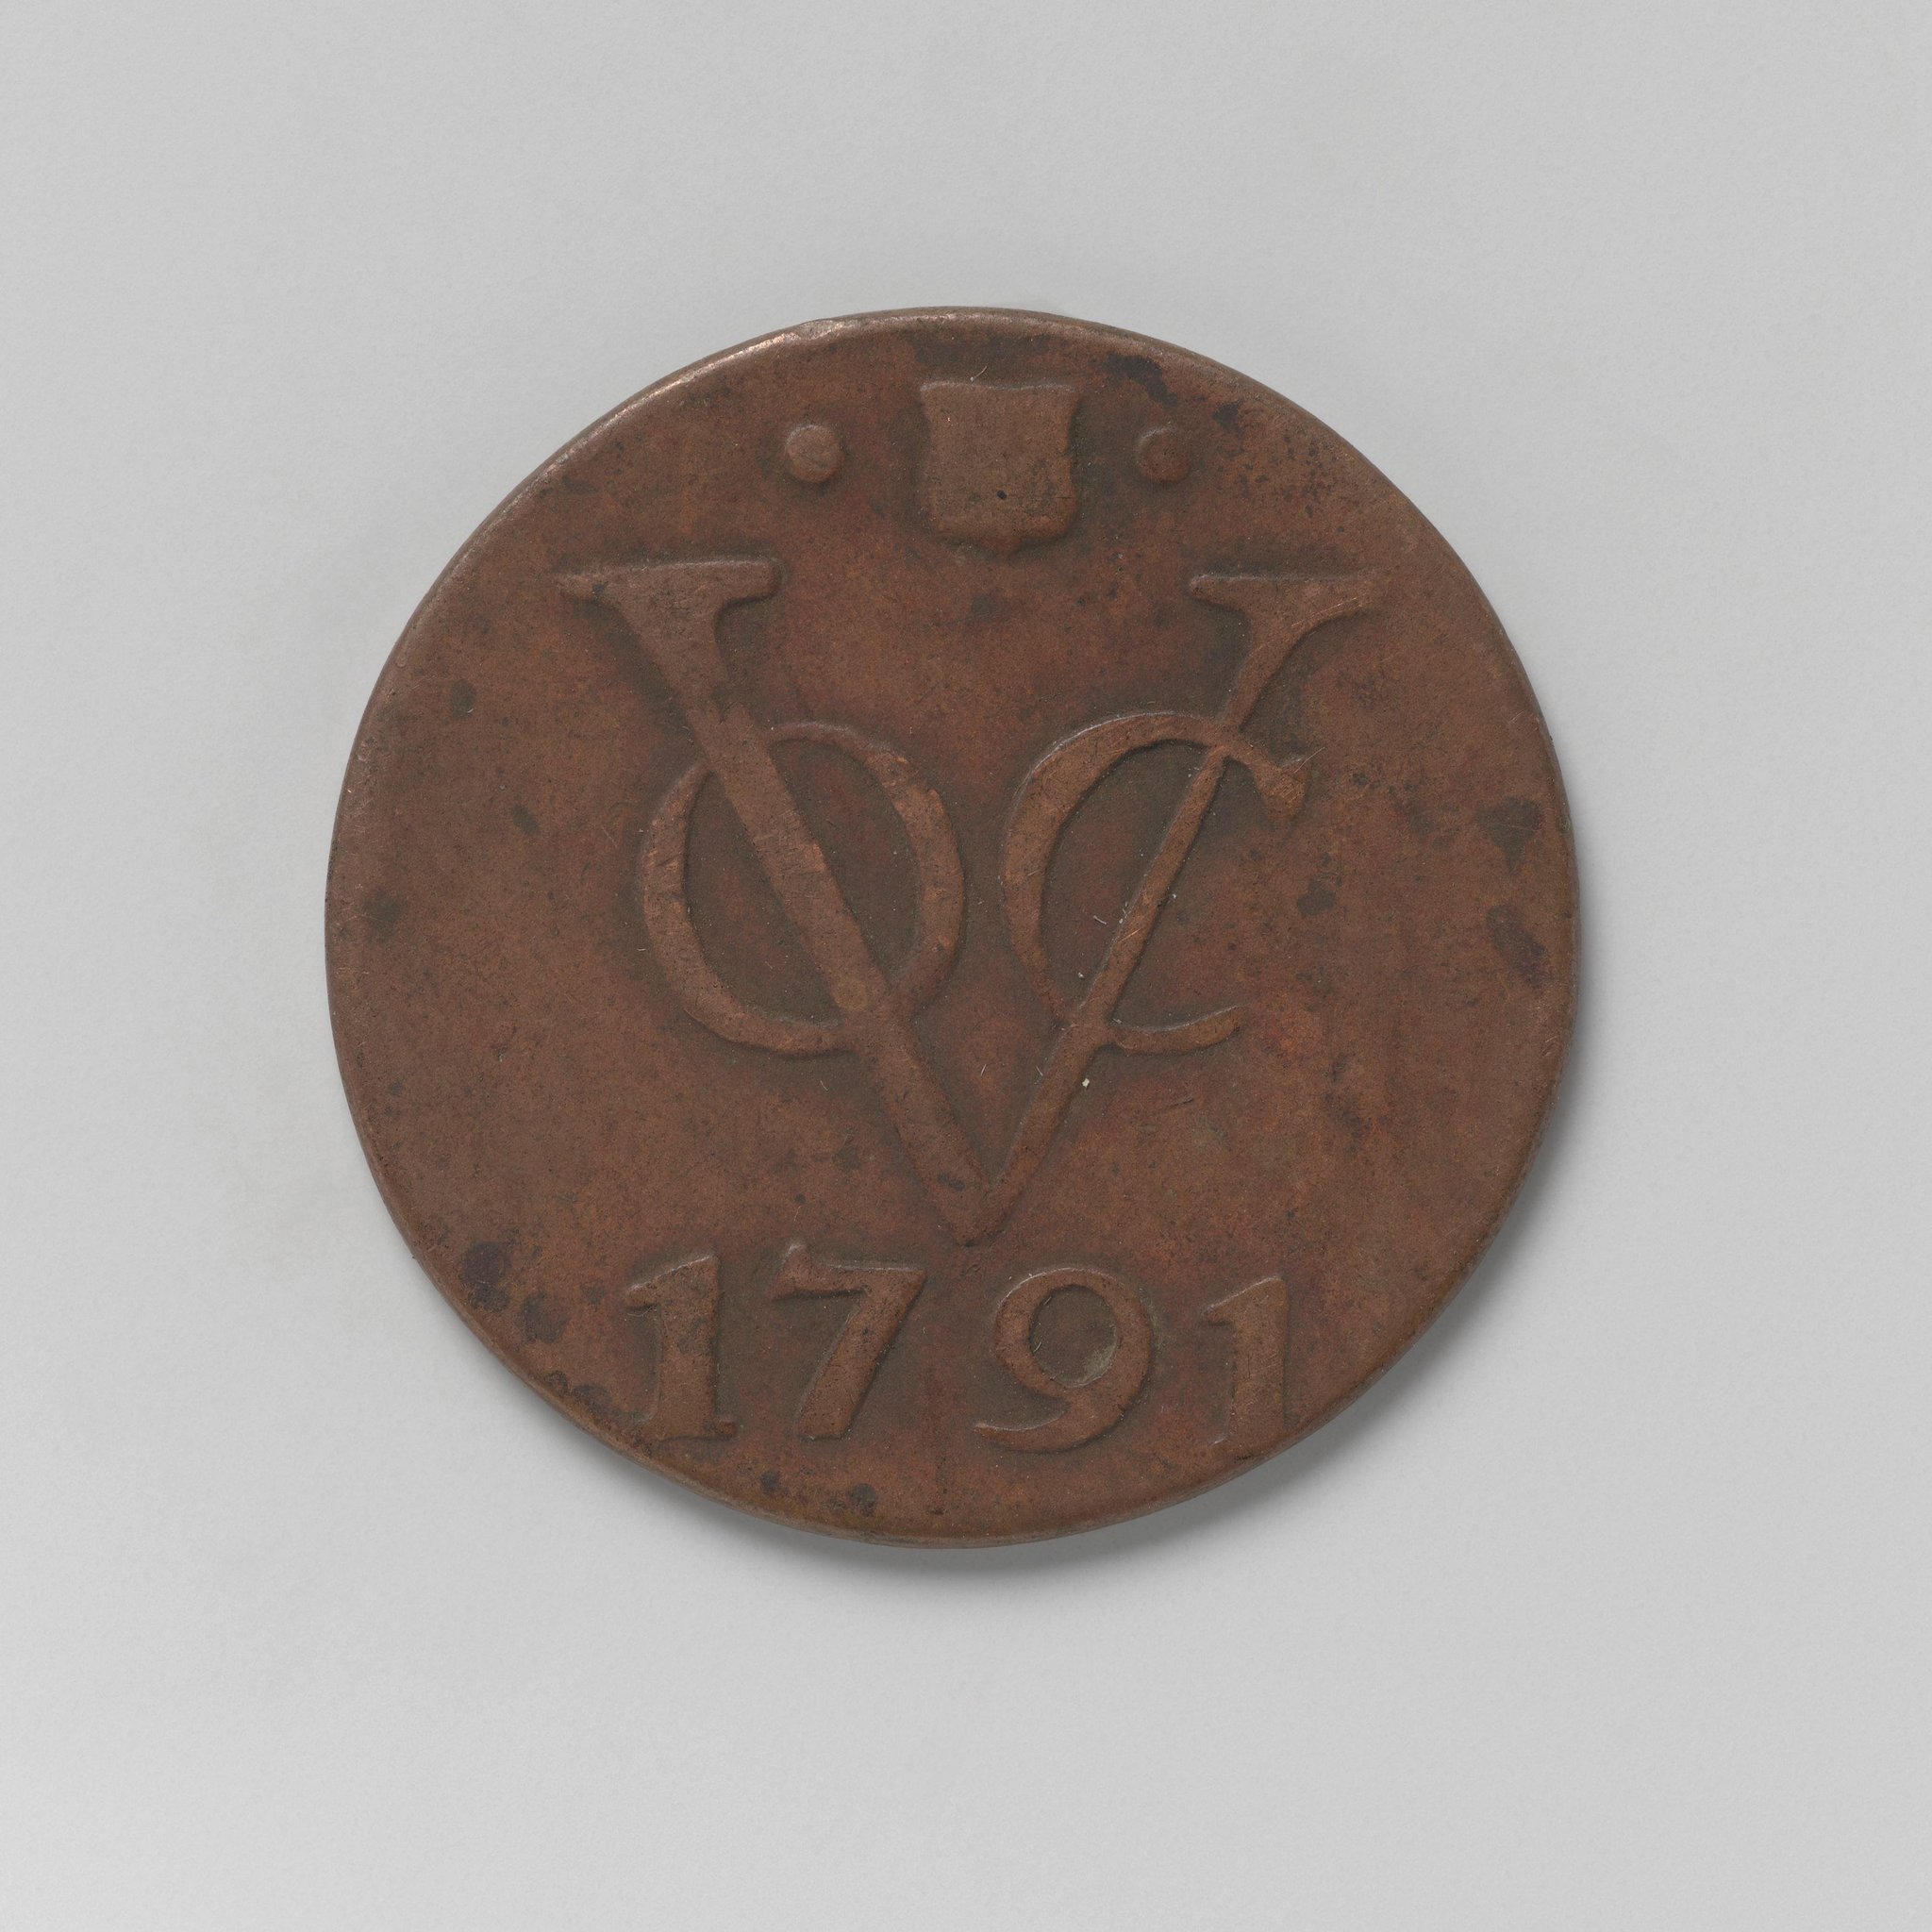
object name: coin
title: VOC, duit, stad Utrecht,1791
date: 1791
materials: copper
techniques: striking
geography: utrecht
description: Koperen munt. Voorzijde: op balk, waaronder guirlande, staand, door twee leeuwen gehouden gekroond wapenschild van de stad Utrecht. Keerzijde: monogram van de VOC, waarboven muntteken en waaronder jaartal. Gladde rand.